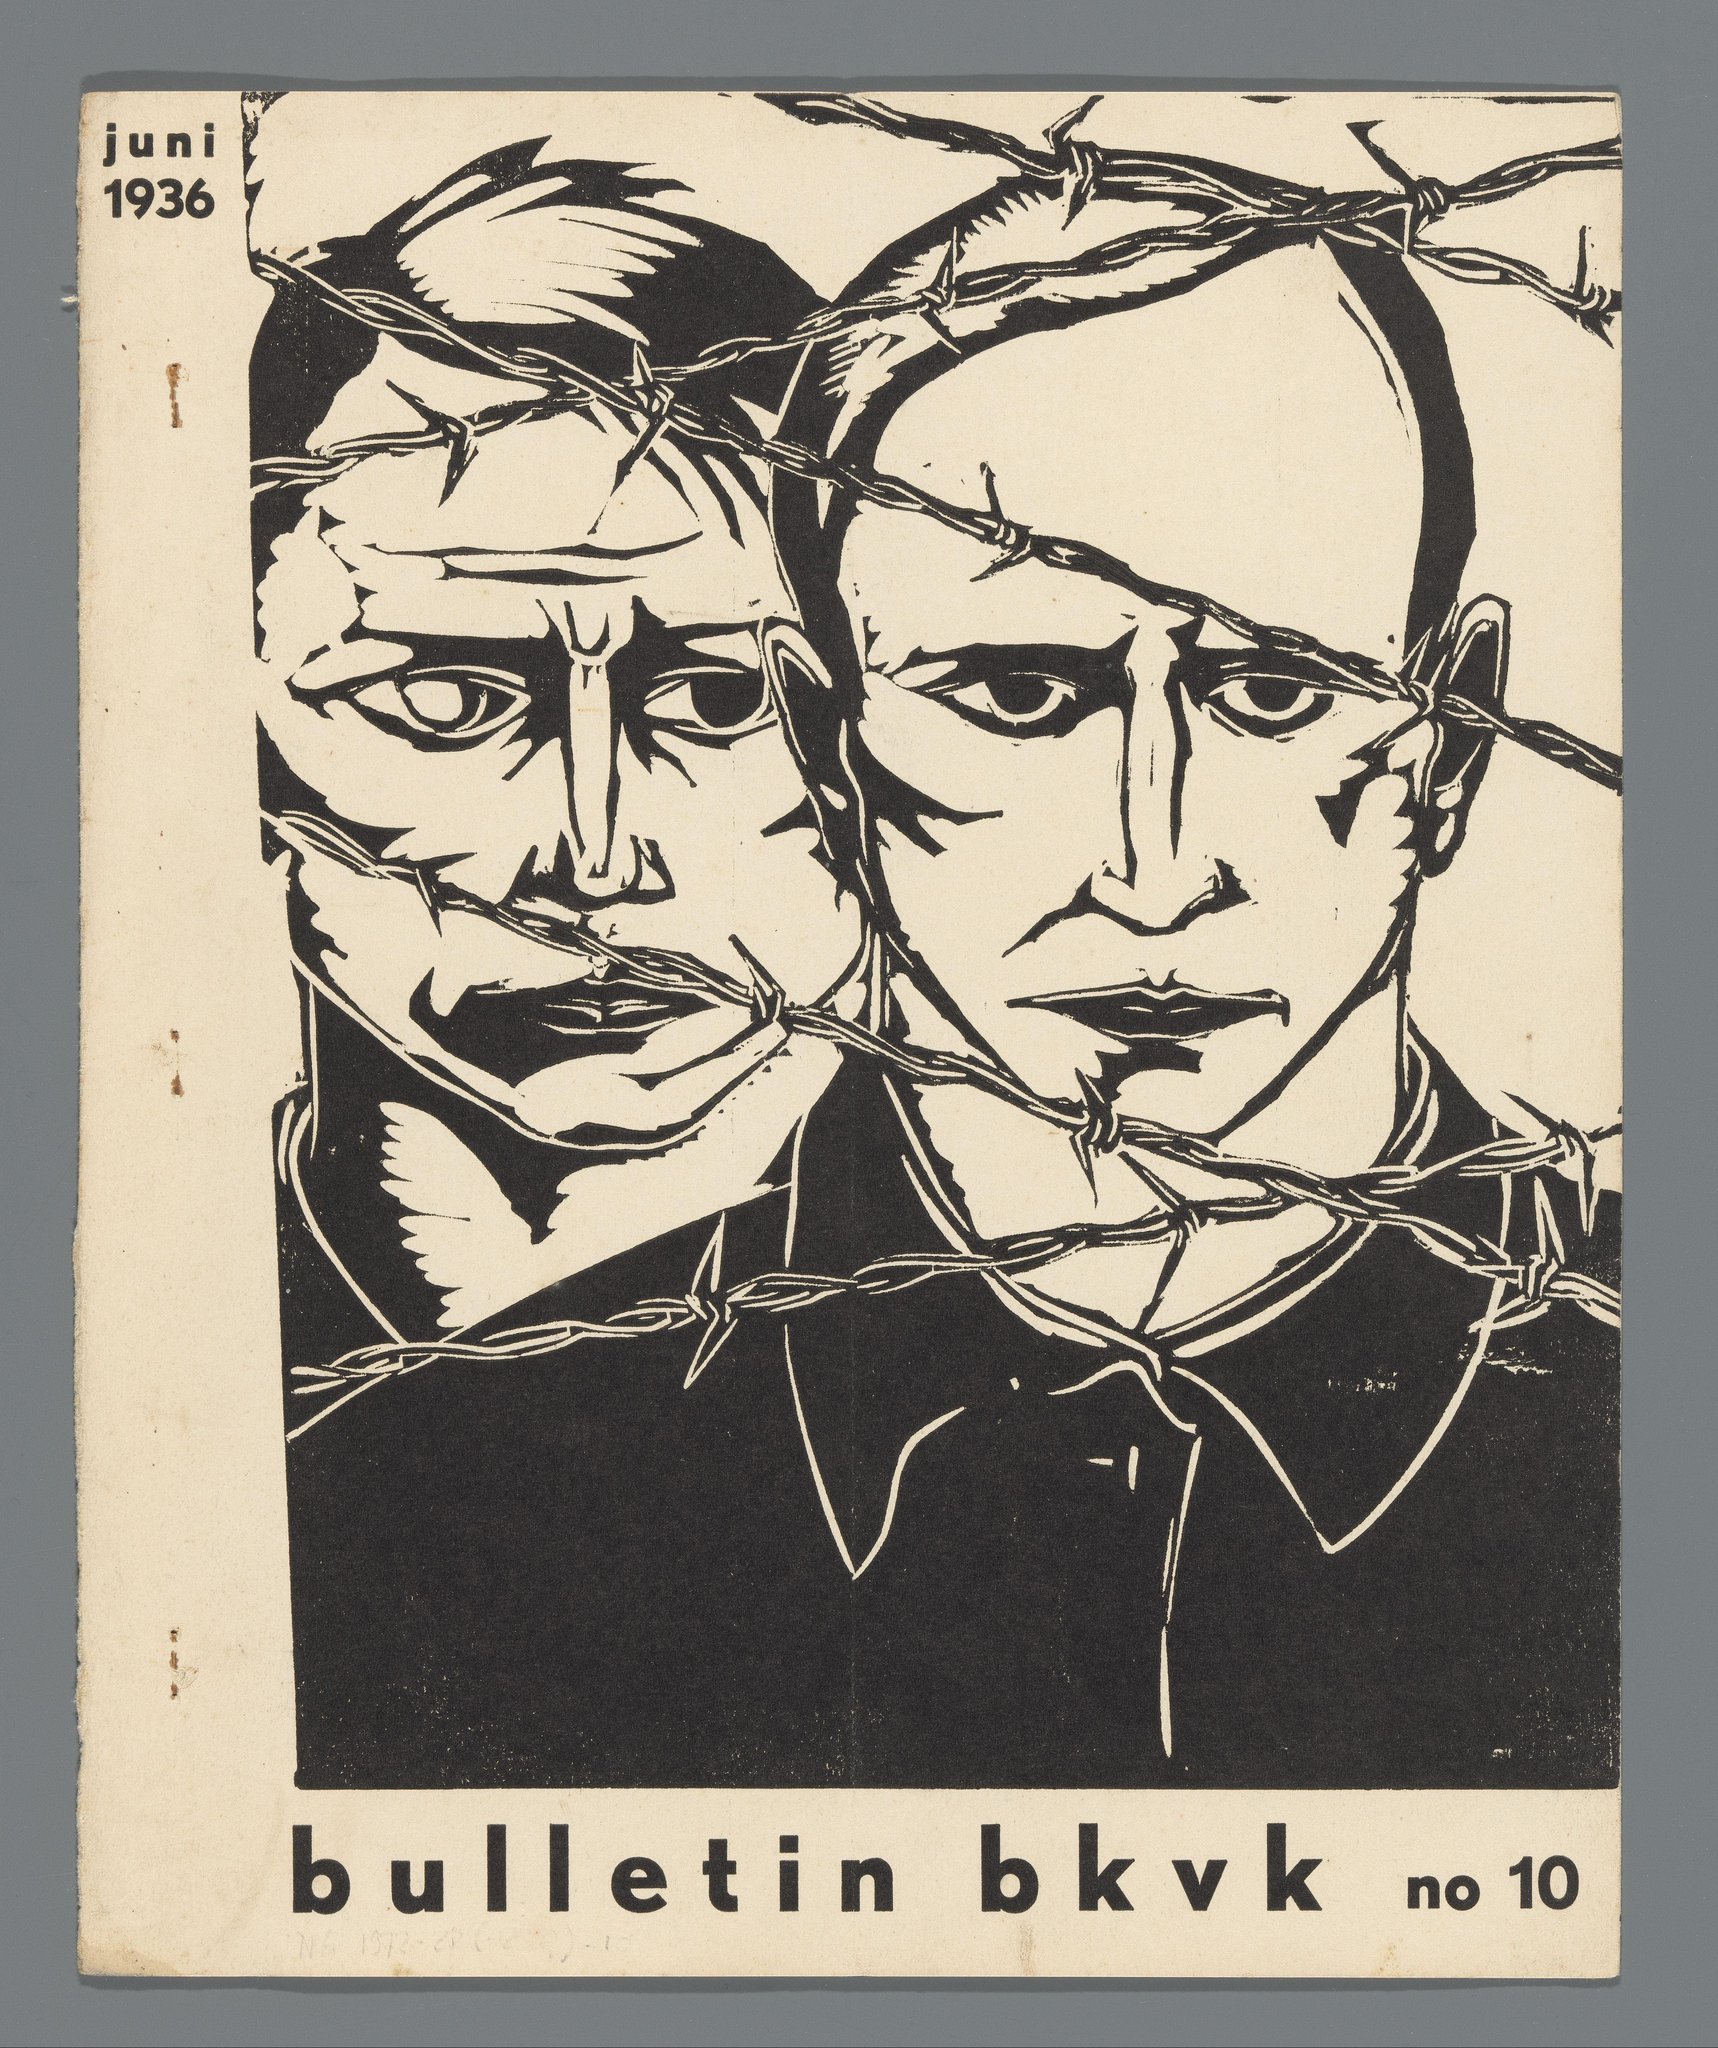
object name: wrapper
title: Magazine Covers Bond van Kunstenaars ter verdediging van de Kulturele Rechten (Association of Artists in Defence of Cultural Rights)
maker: Anonymous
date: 1906-1936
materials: paper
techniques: linocut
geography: netherlands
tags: barbed wire, imprisonment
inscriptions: date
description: In 1935, a group of Dutch, left-wing artists campaigned against the rise of fascism. Human rights, the constitution, and art subsidies were under threat. Militarism, war, nationalism, violence and oppression threatened. The artists formed a union that organized lectures and protest exhibitions. These pages are from their bulletin calling for resistance.